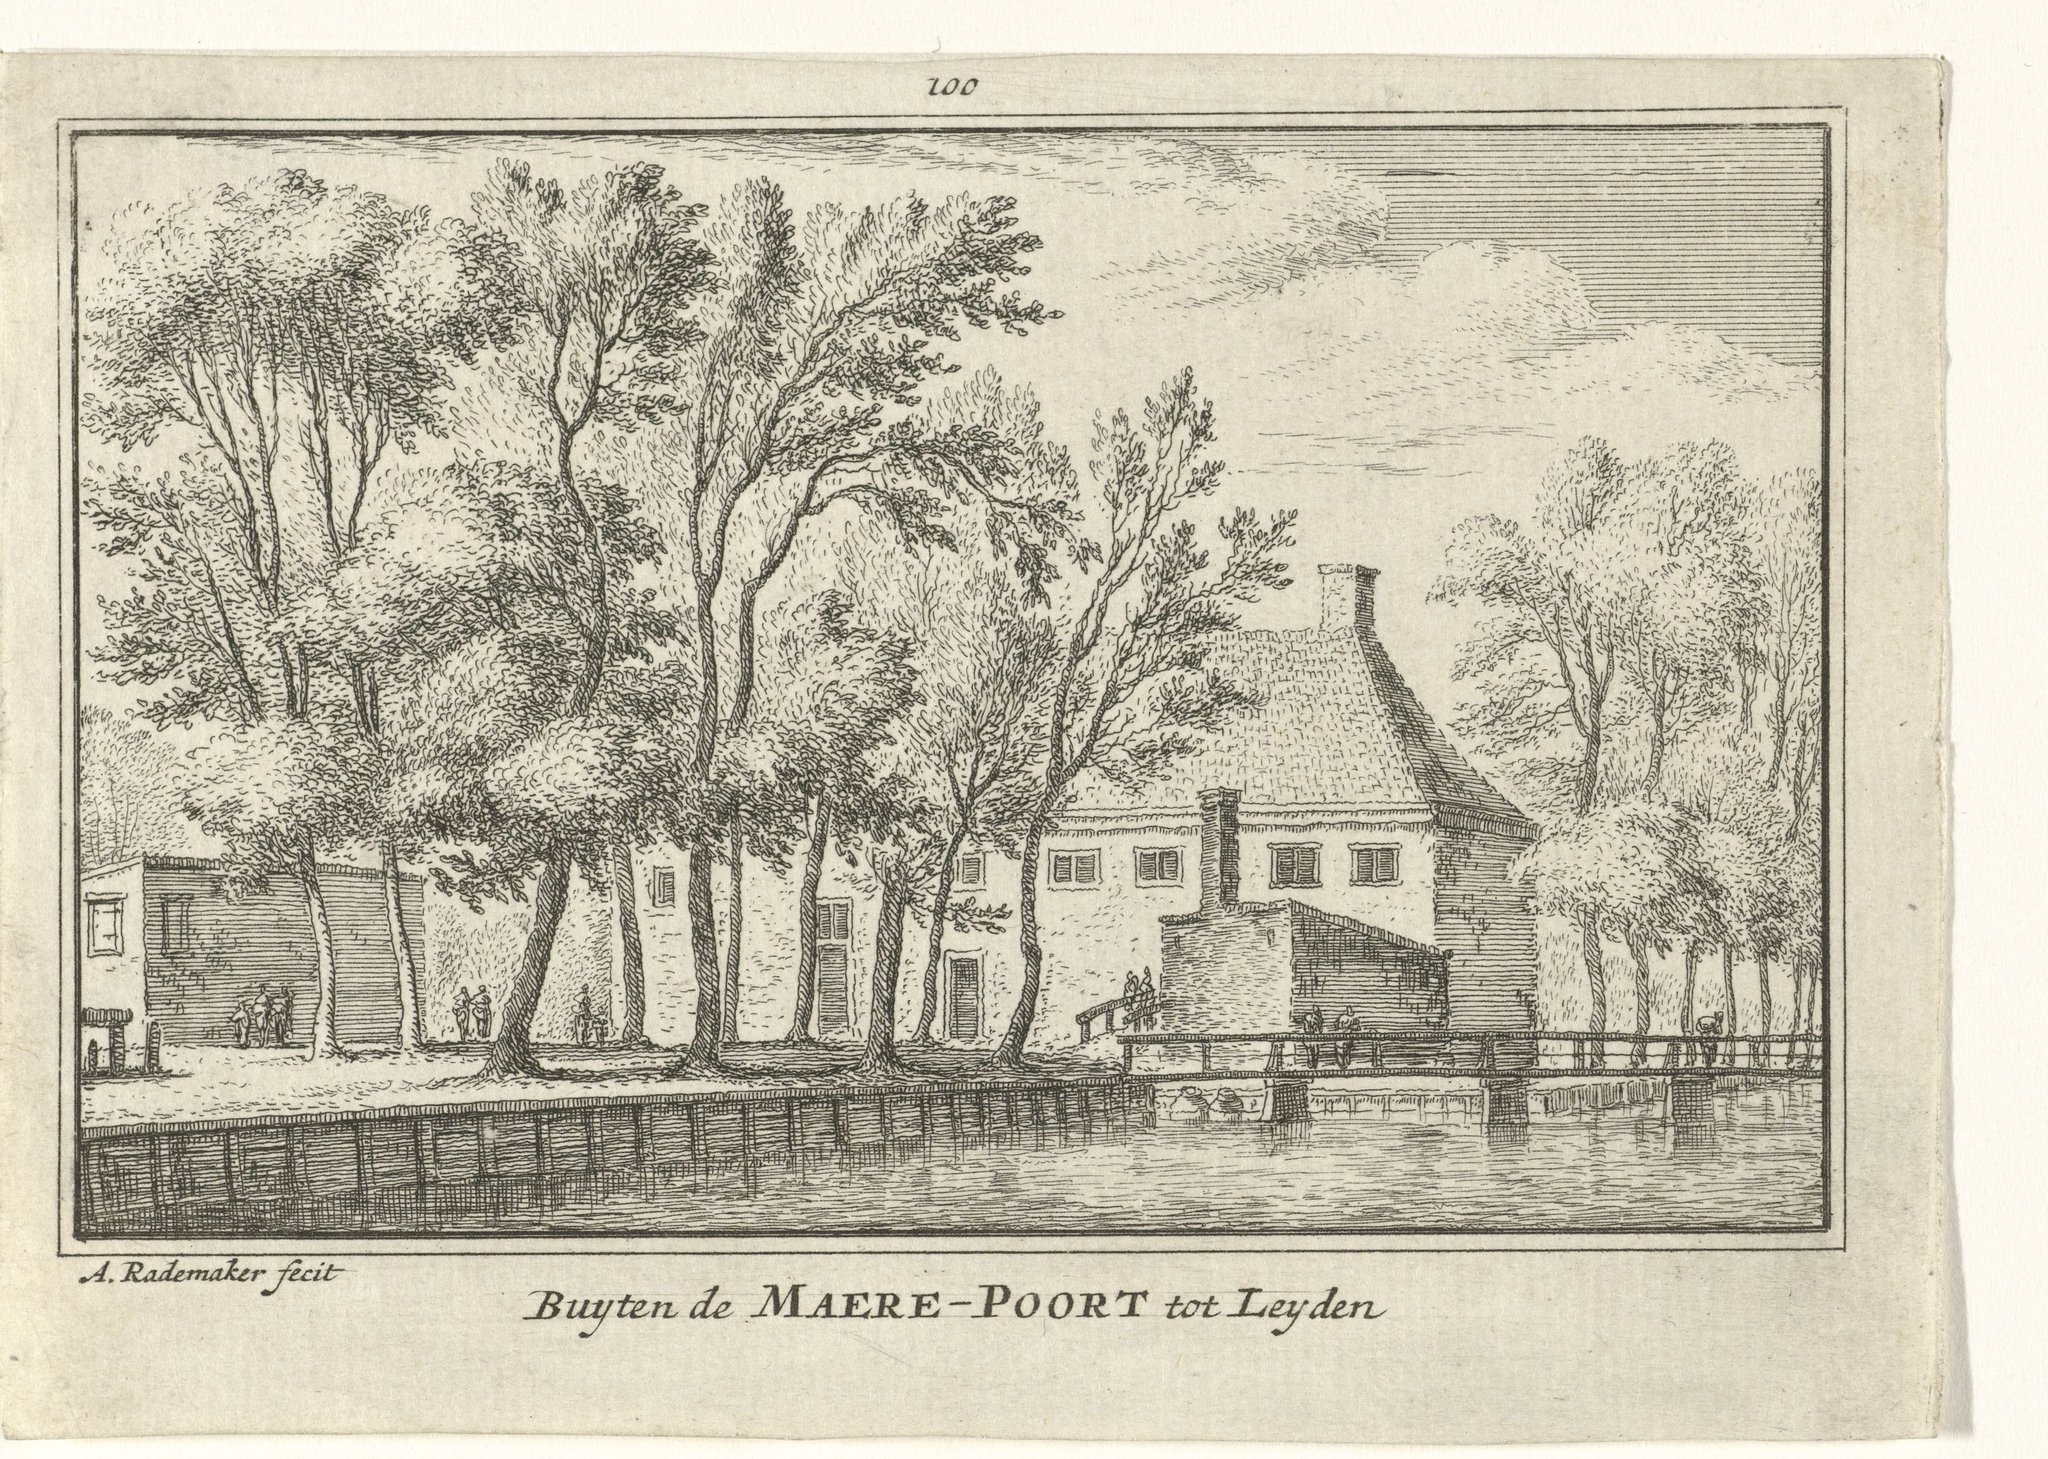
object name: print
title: Gezicht op de brug bij de Marepoort te Leiden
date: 1727-1733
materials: paper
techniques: etching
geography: amsterdam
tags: bridge, bridge in city across river, canal, etc., leiden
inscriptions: collector's mark: Lugt 2228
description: Illustratie uit: Abraham Rademaker, Matthaeus Brouërius van Niedek, Isaac Le Long, Kabinet van Nederlandsche en Kleefsche outheden en (...) voorname stads- en landgebouwen, Willem Barents en Antoni Schoonenburg: Amsterdam, 1727-1733, ill. nr. 100.